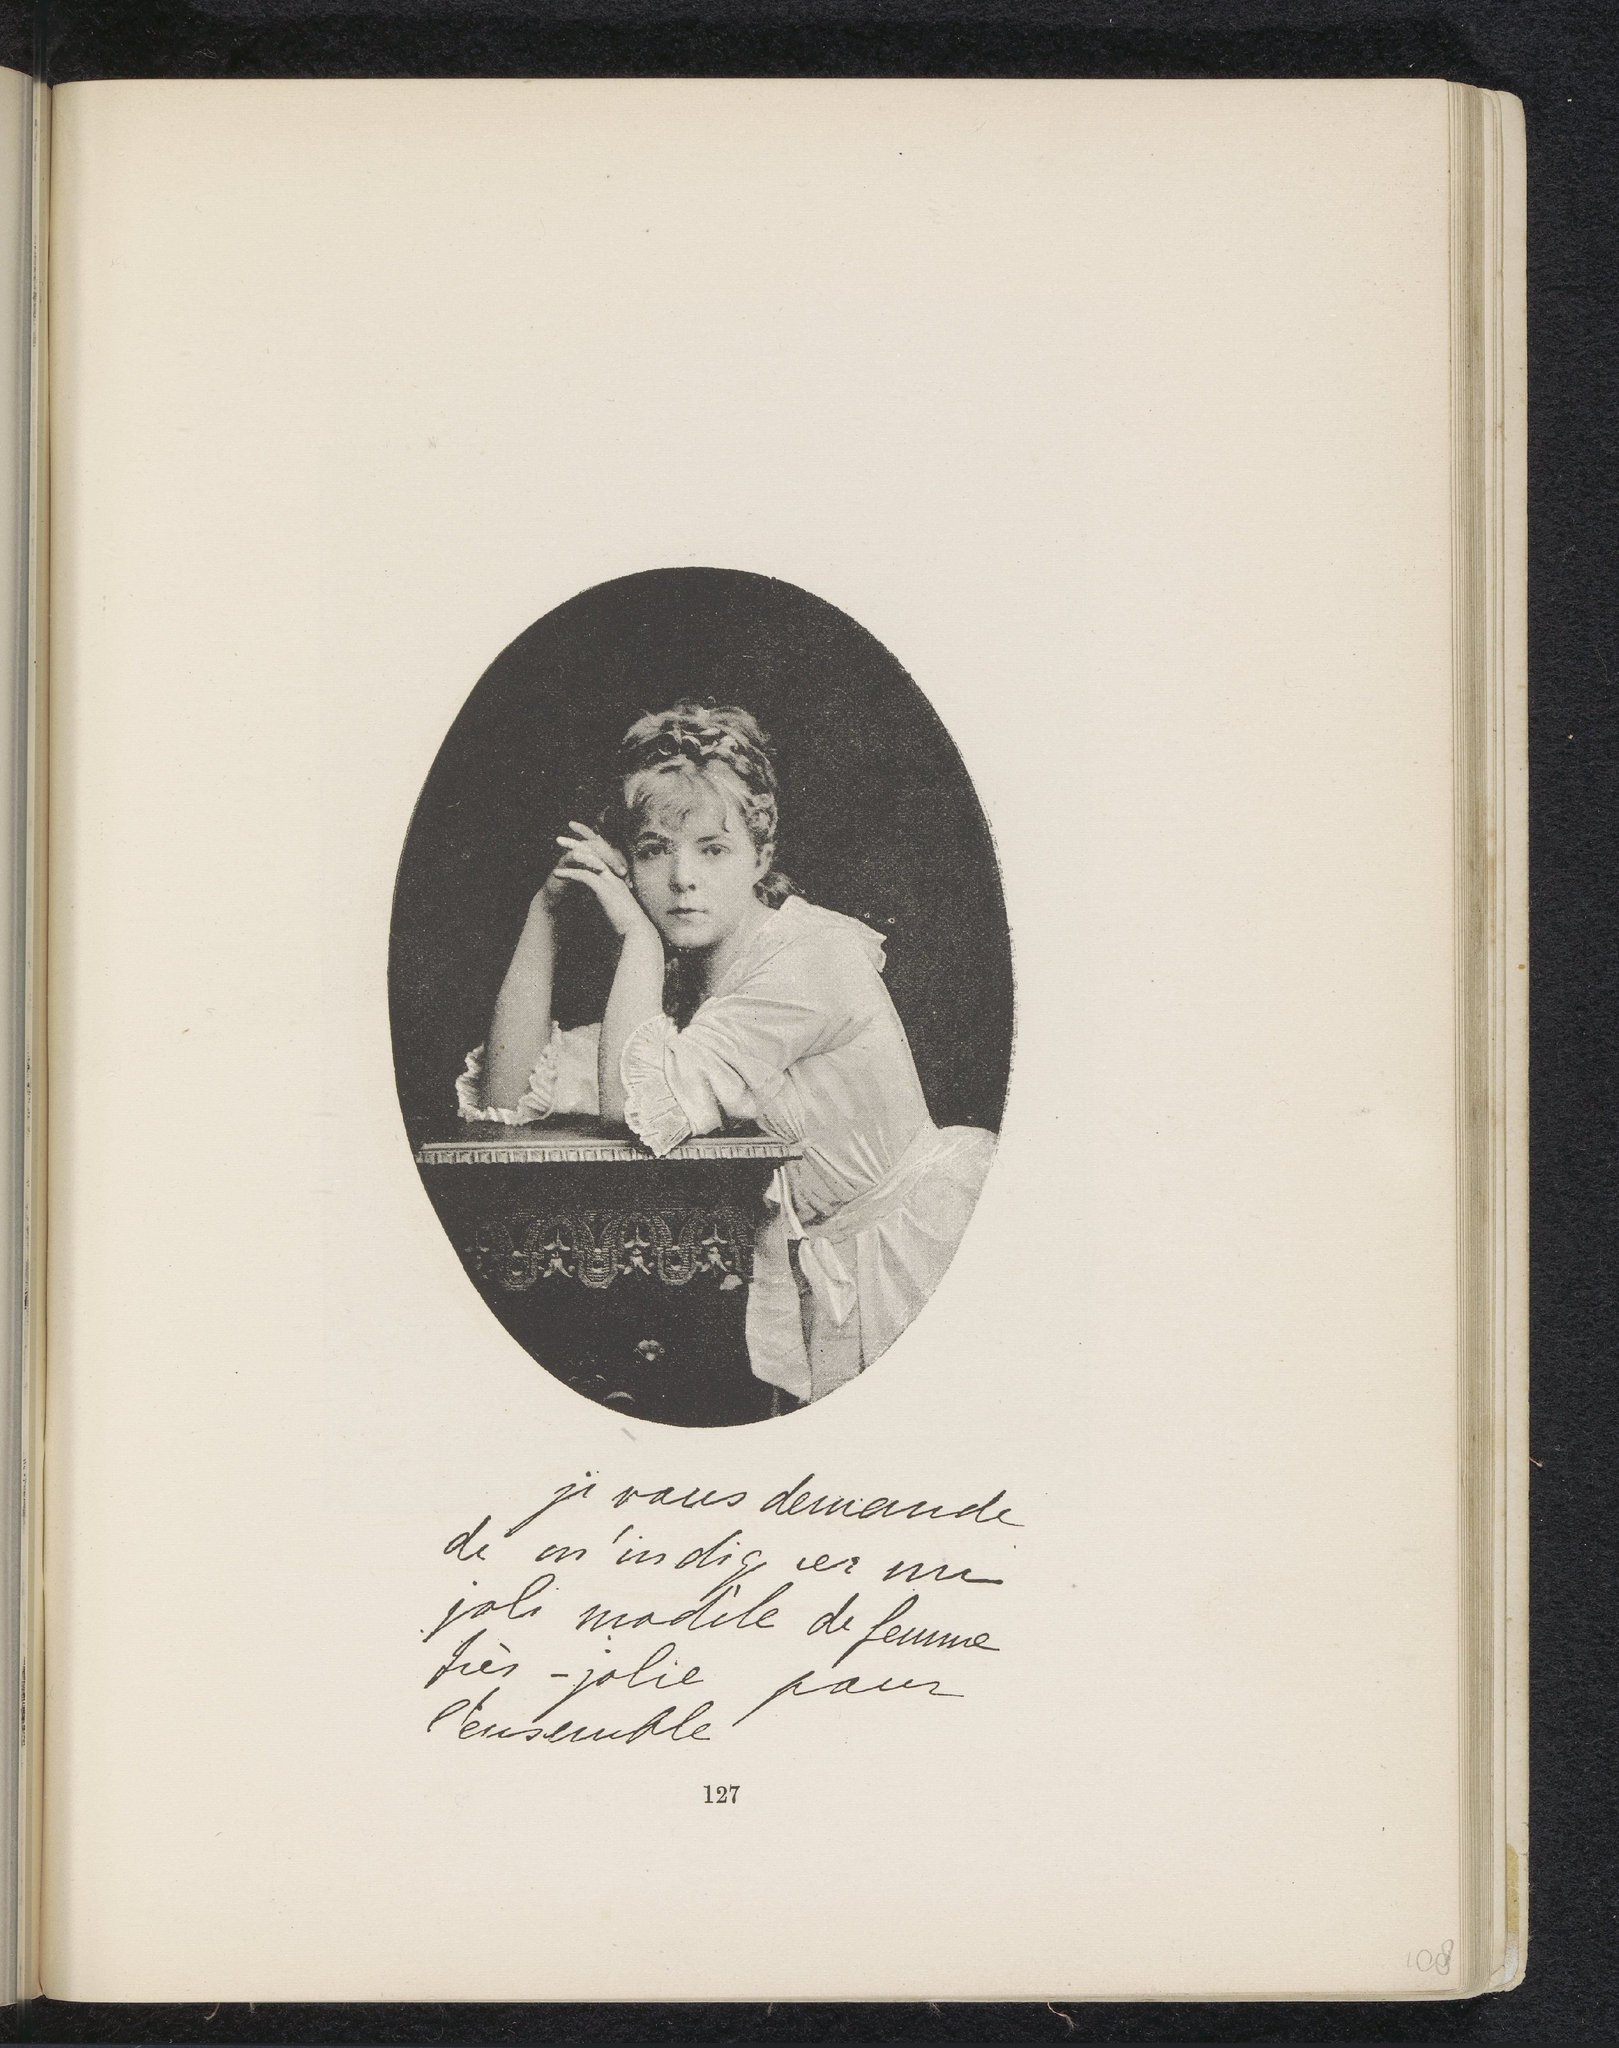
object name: page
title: Portret van Marie Bashkirtseff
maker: Anonymous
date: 1881-1891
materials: paper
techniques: autotype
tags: portrait, self-portrait of painter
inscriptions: inscription